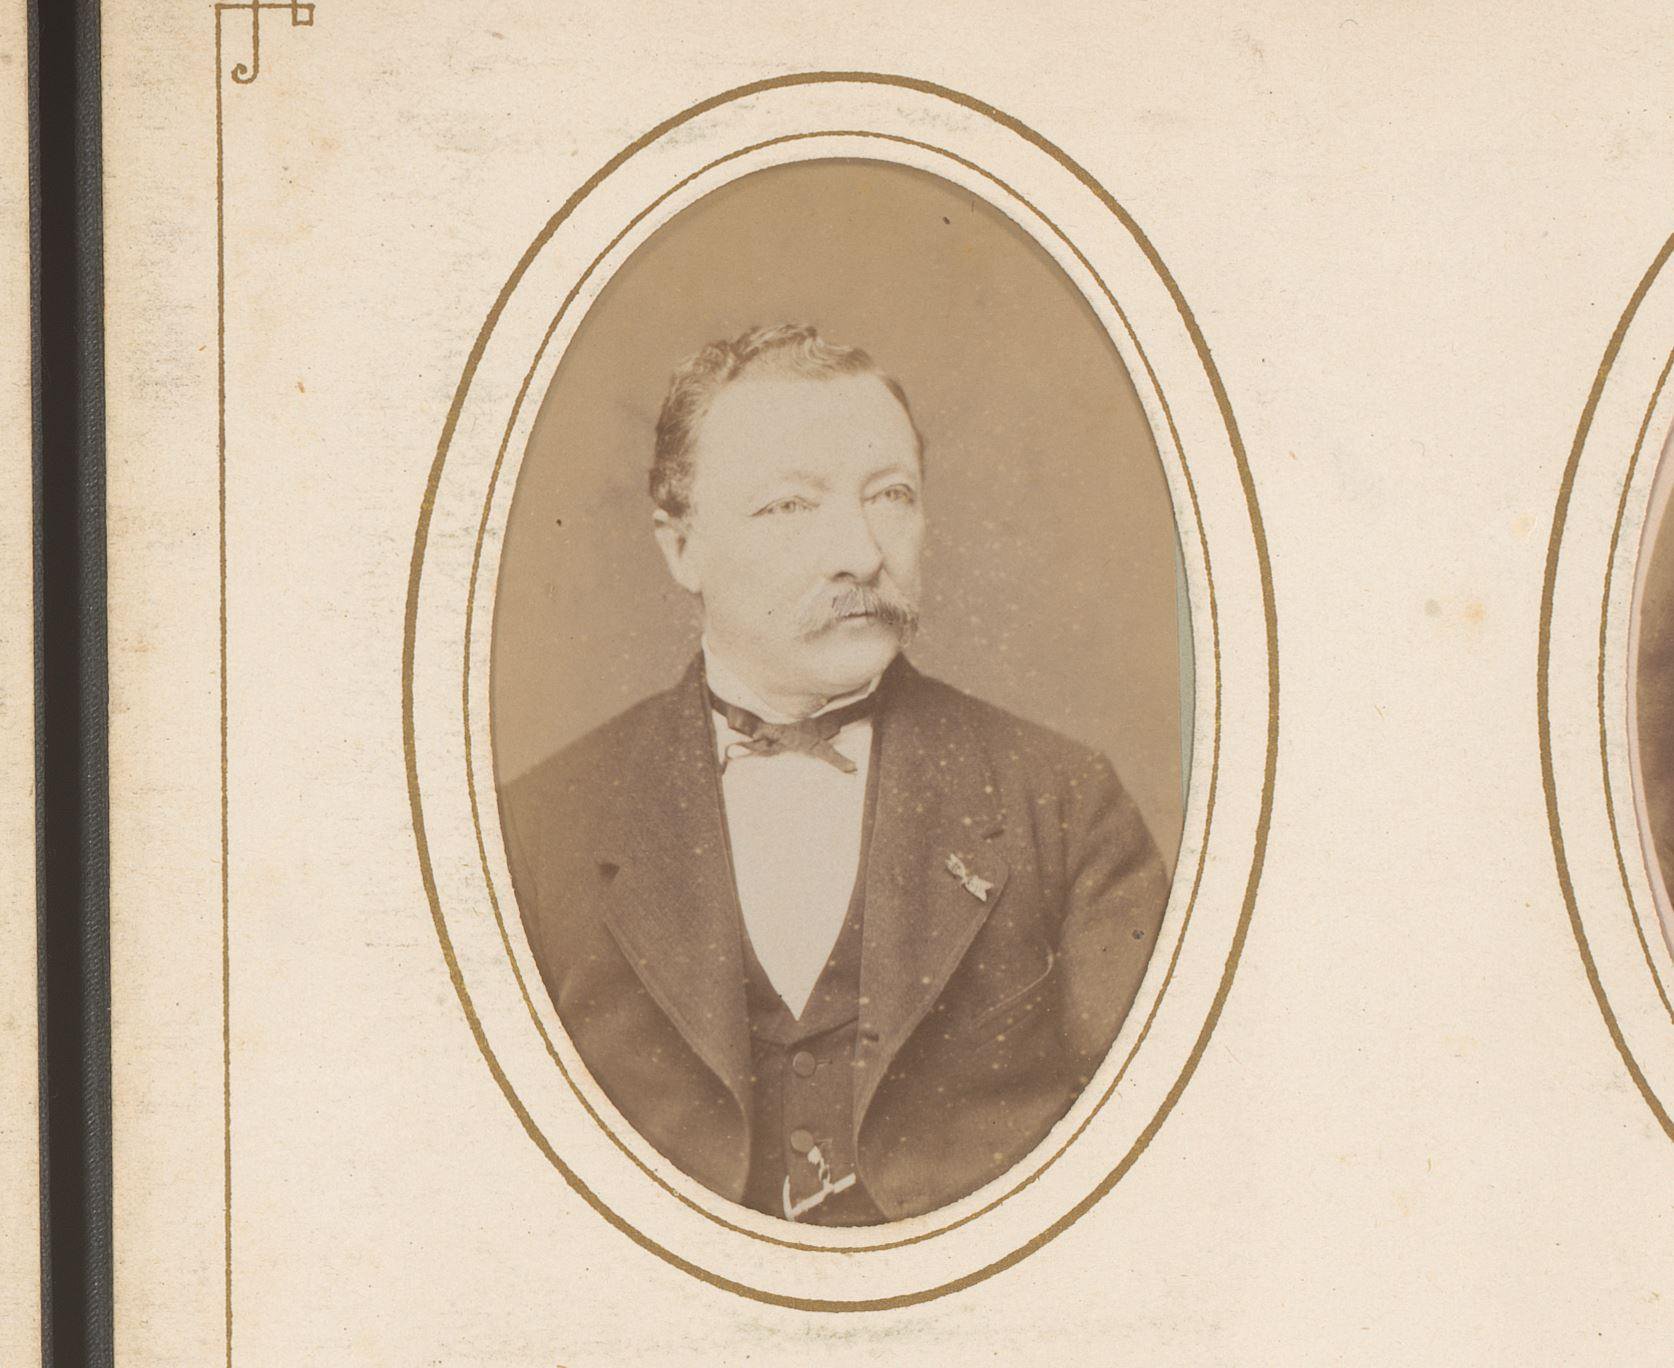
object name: photograph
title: Portret van een man met snor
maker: eugene guérin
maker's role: fotograaf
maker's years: 1845-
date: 1878-1885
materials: cardboard, photographic support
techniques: albumen print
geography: brussels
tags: moustache, historical persons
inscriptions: inscription: ‘MÉDAILLE D'OR NAPLES 1874/ MENTION HONORABLE EXPon UNIVle PARIS 1878/ Eugène Guérin/ 142, Rue Royale, 142/ Bruxelles/ Tous les clichés sont conservés.’